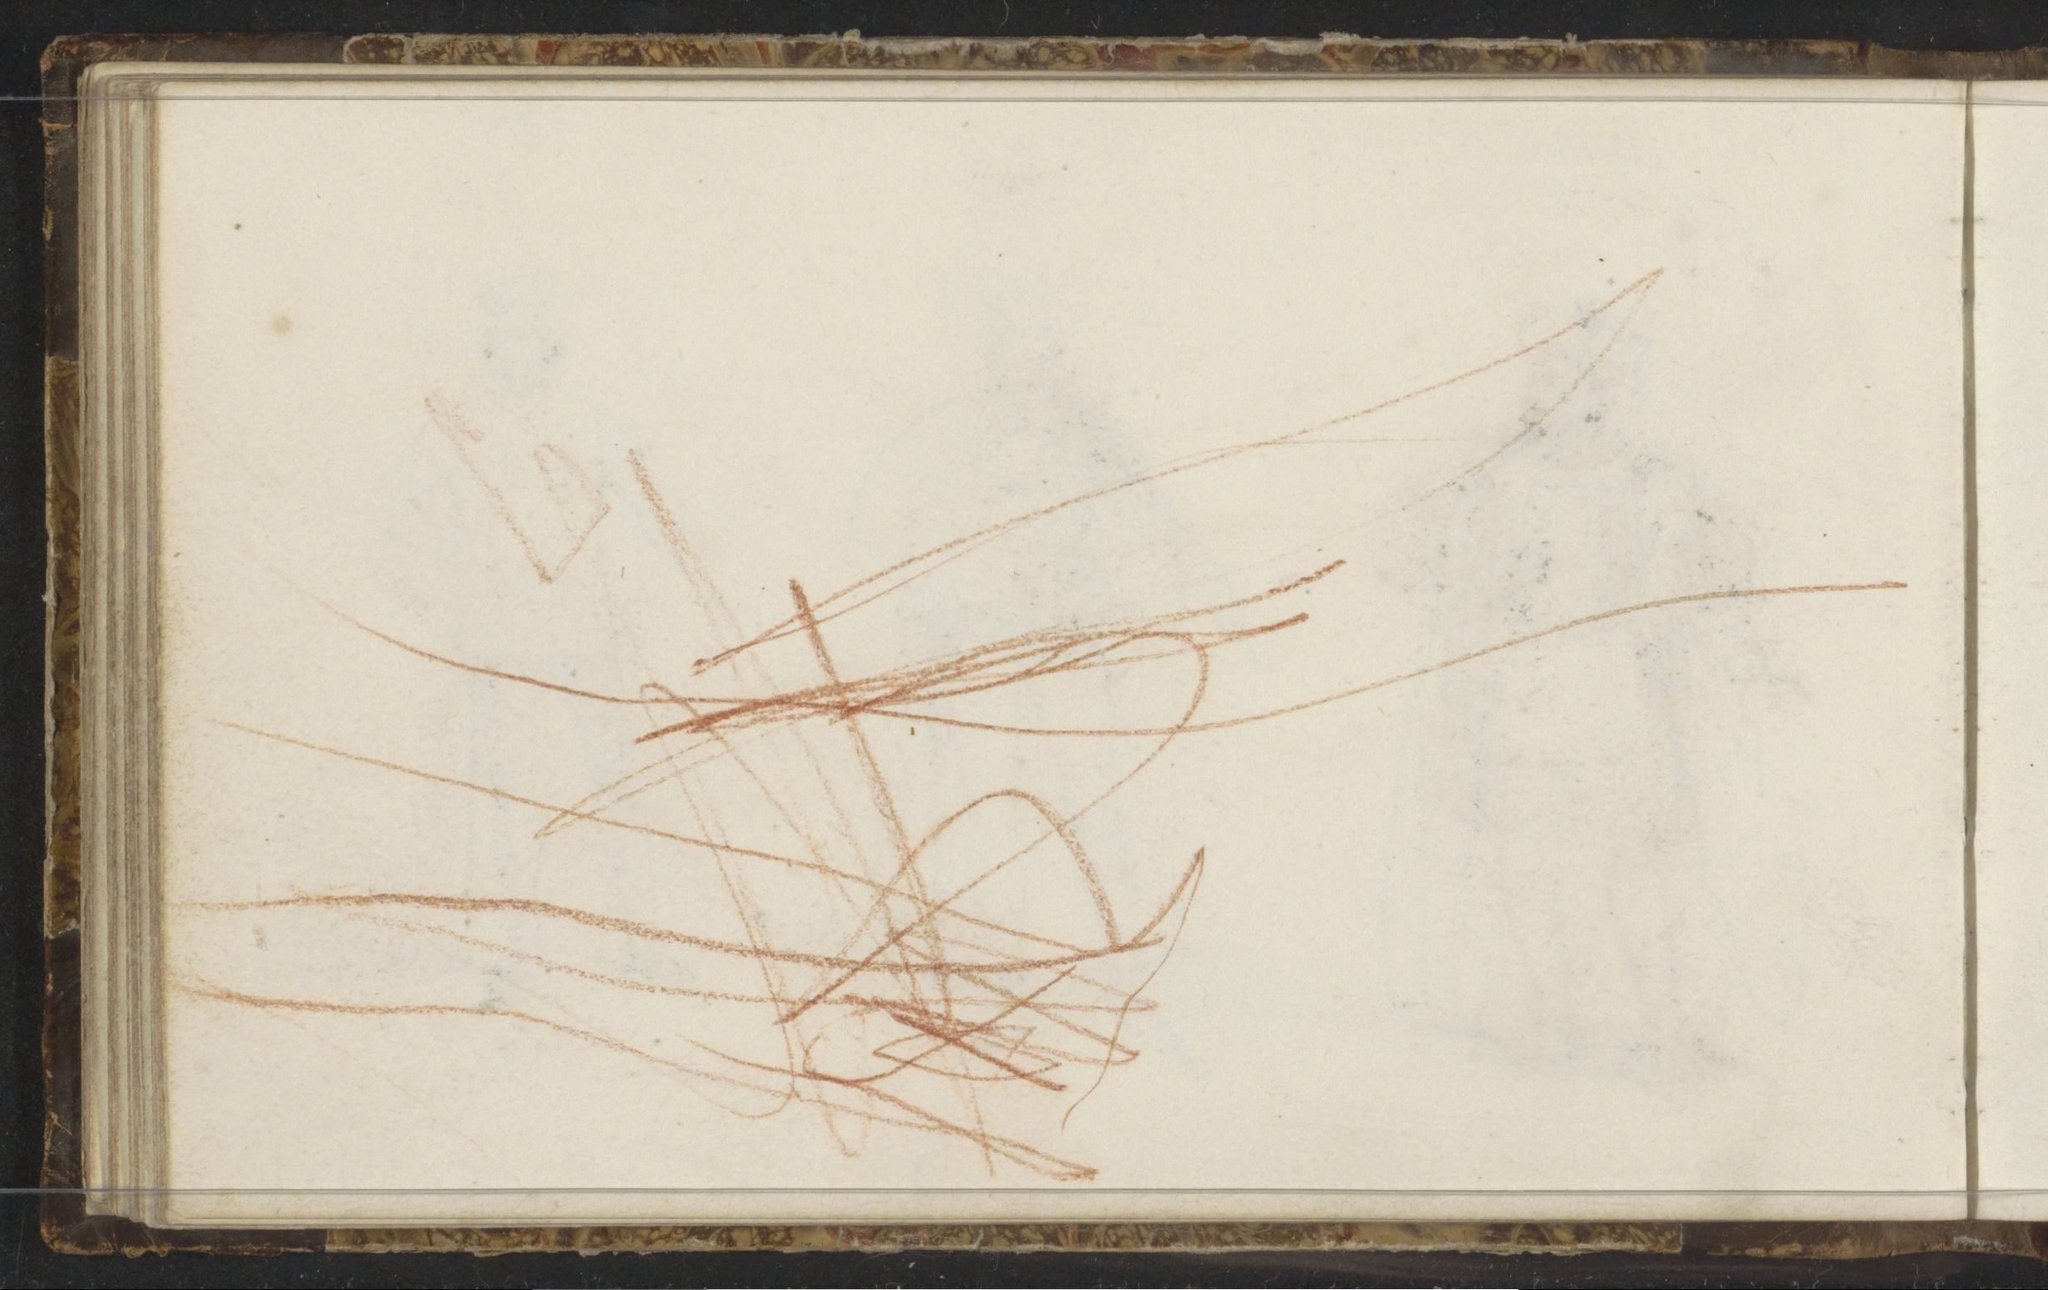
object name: sketchbook leaf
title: Studie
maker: willem hendrik schmidt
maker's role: draughtsman, painter, print maker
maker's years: 1809-1849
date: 1819-1849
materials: chalk, paper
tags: historical costume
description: Blad 30 verso uit een schetsboek met 60 bladen.